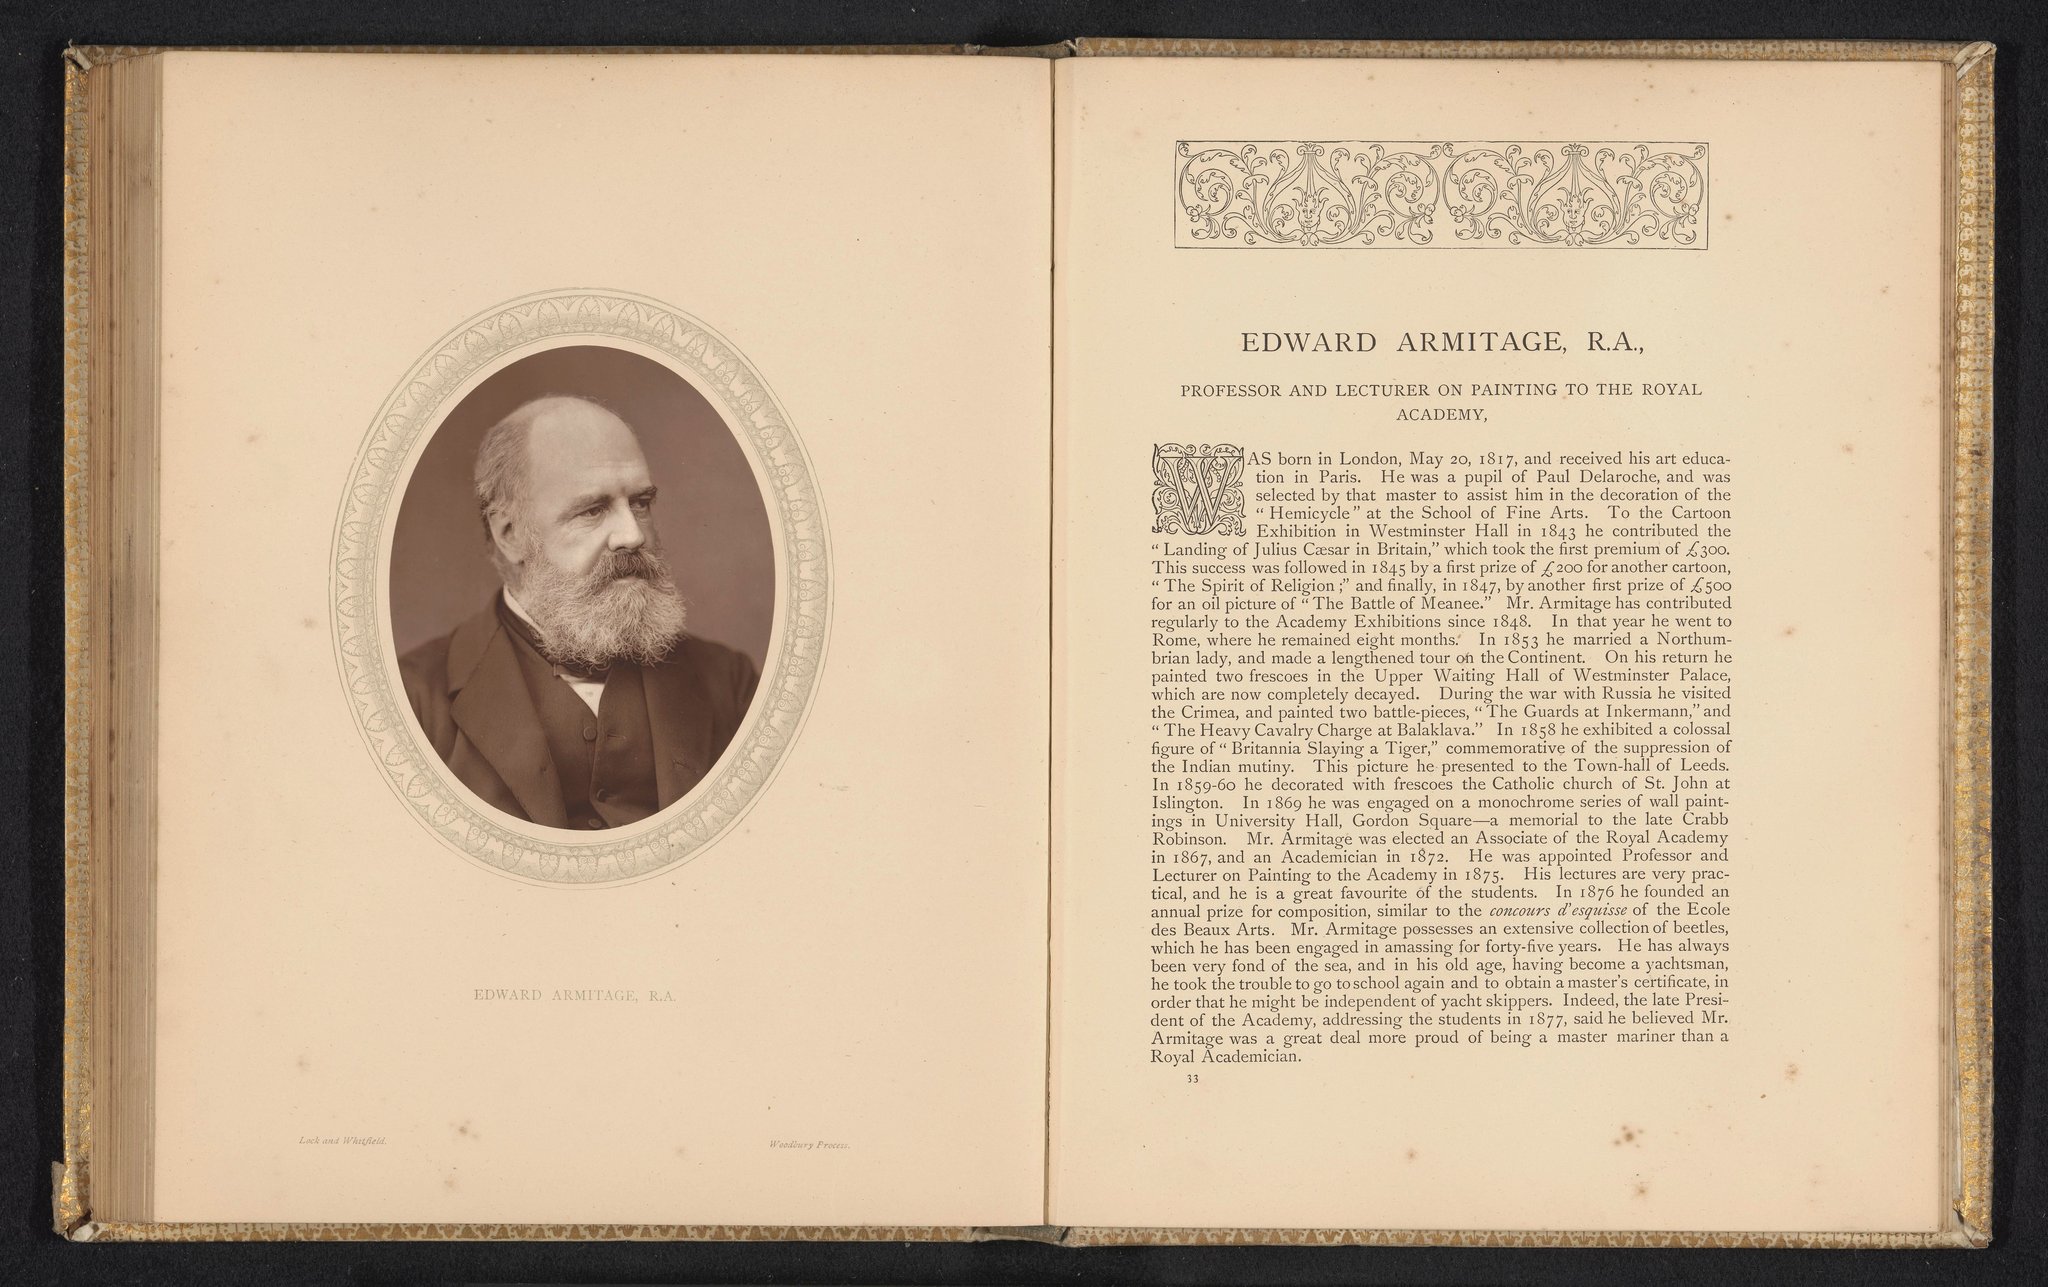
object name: page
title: Edward Armitage, R.A.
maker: Anonymous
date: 1873-1878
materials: paper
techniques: woodburytype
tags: painter, portrait, self-portrait of painter, historical persons (portraits and scenes from the life) (+ (full) bust portrait)